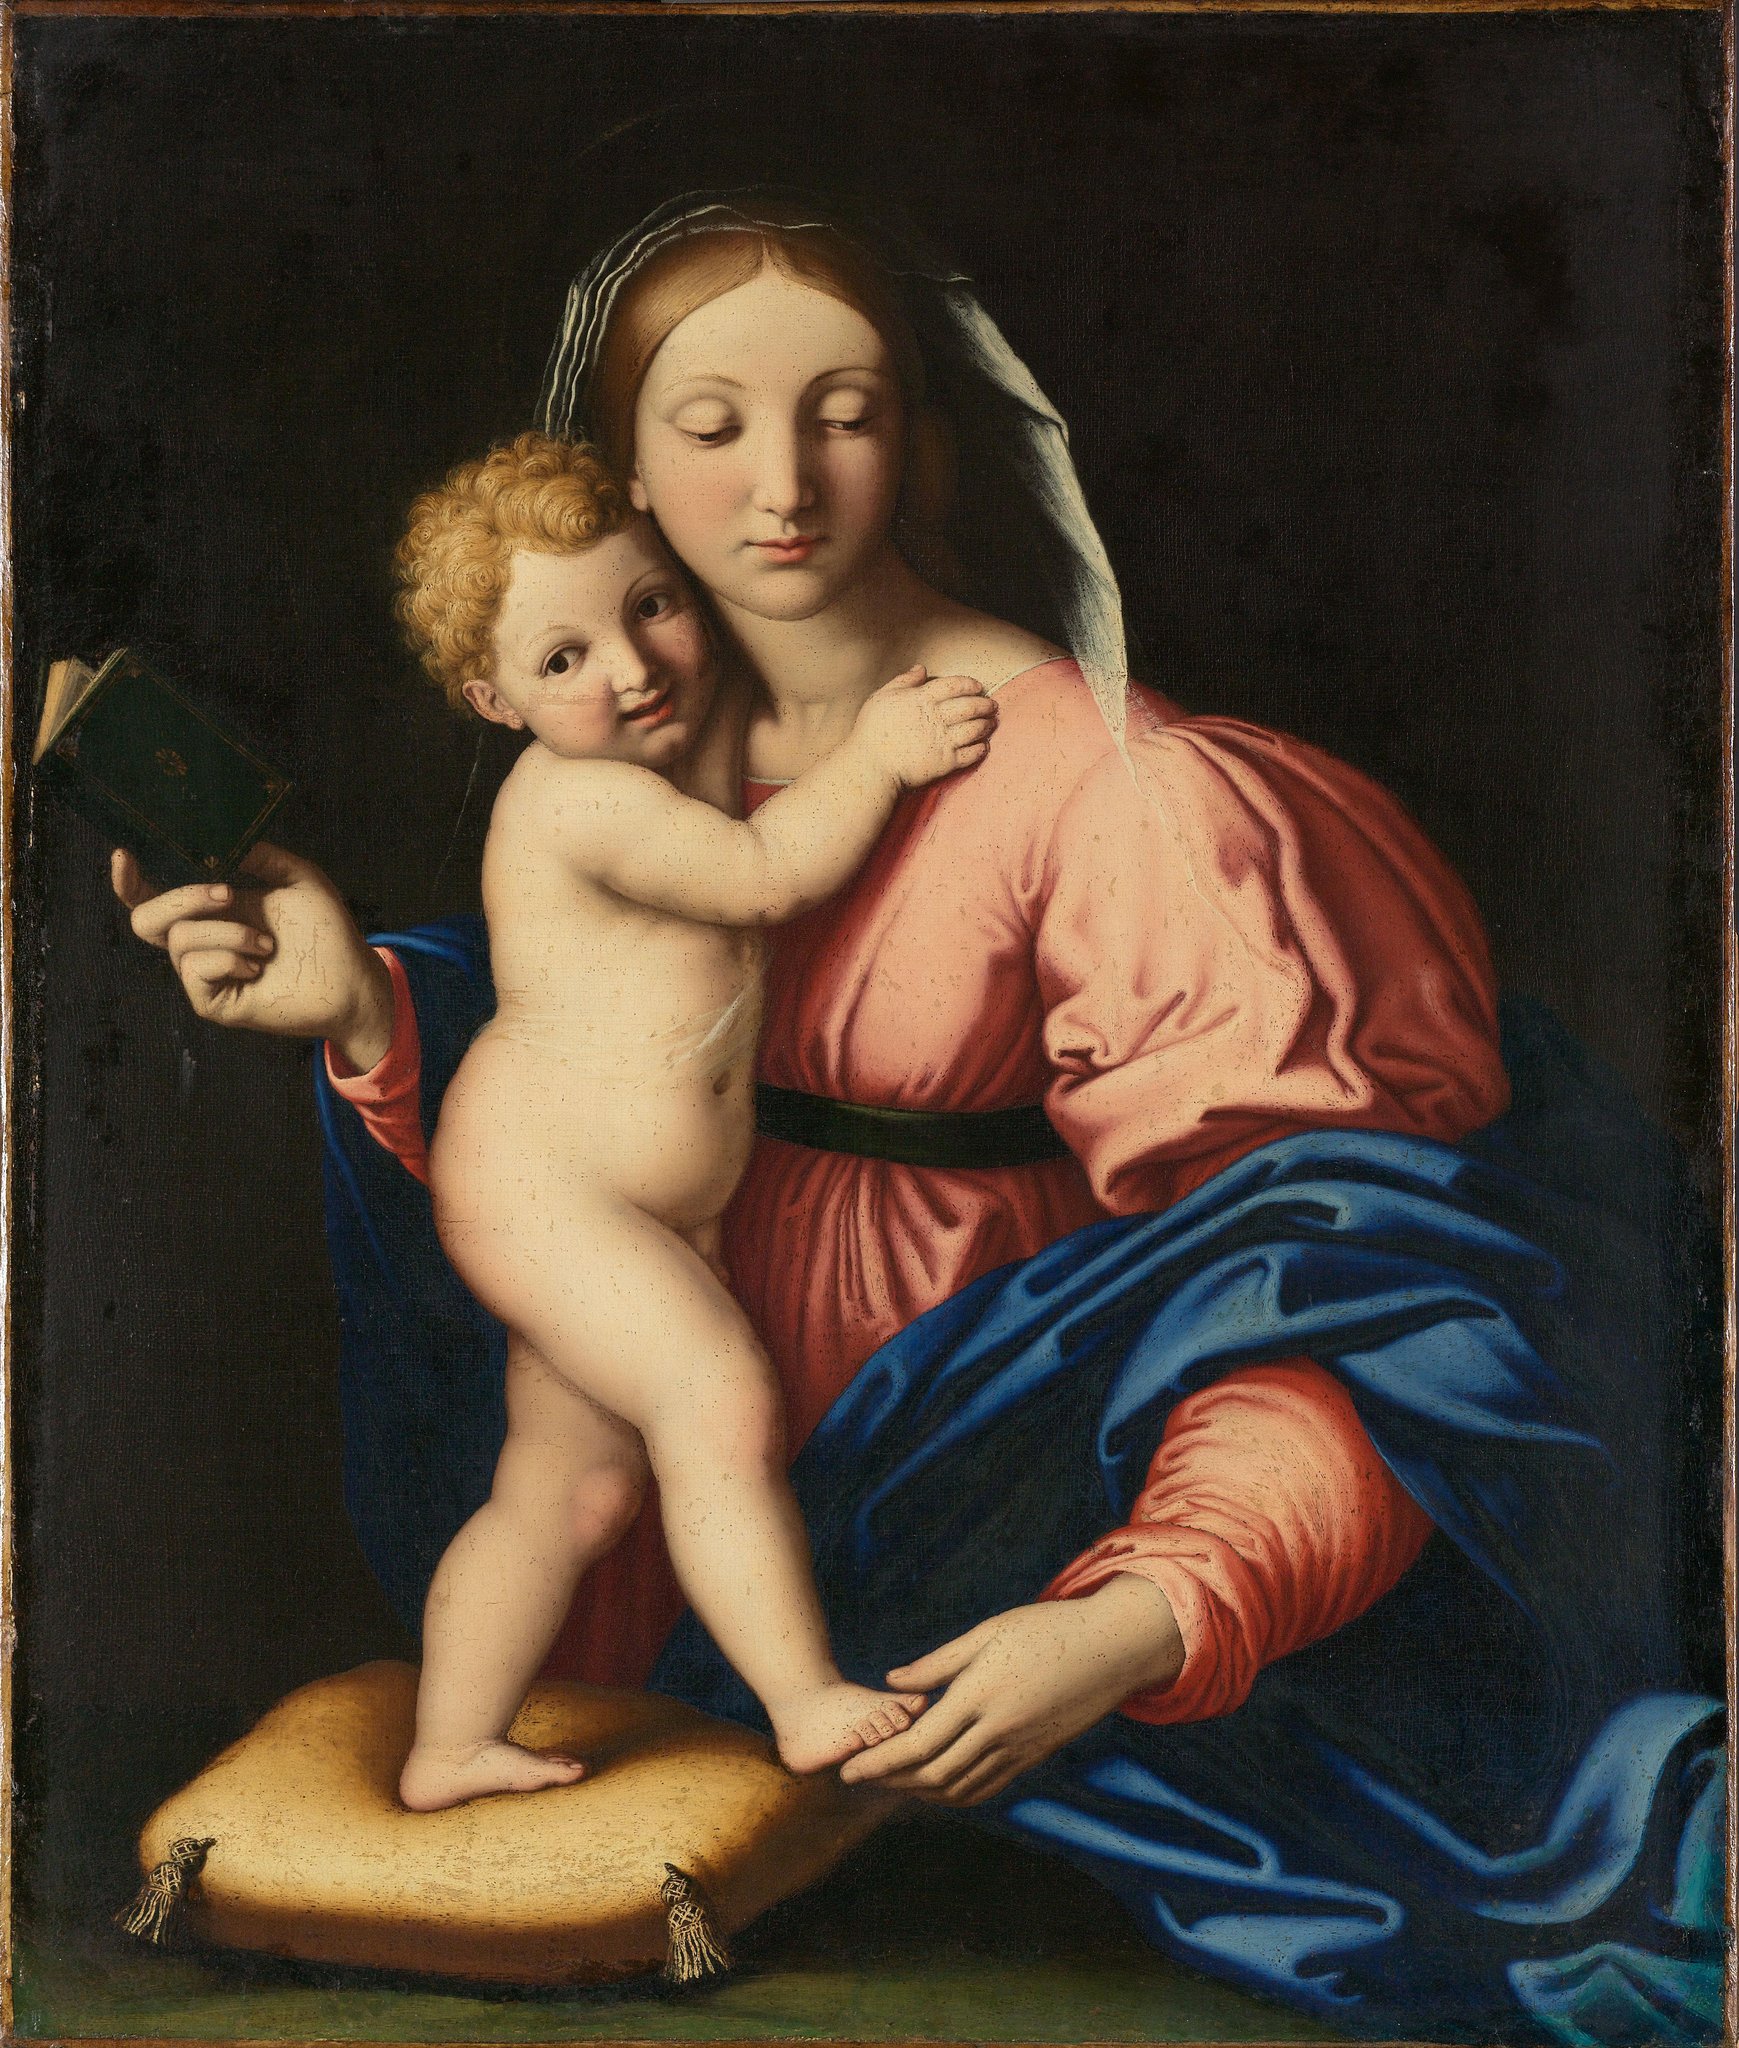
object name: painting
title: Virgin and Child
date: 1640-1699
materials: canvas, oil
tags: mary (standing) with the christ-child in front of her (free-standing or leaning against her); christ-child standing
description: Madonna met het Christuskind staande op een kussen voor zich. Maria heeft in de rechterhand een boekje, met de linkerhand ondersteunt zij het voetje van het Christuskind.